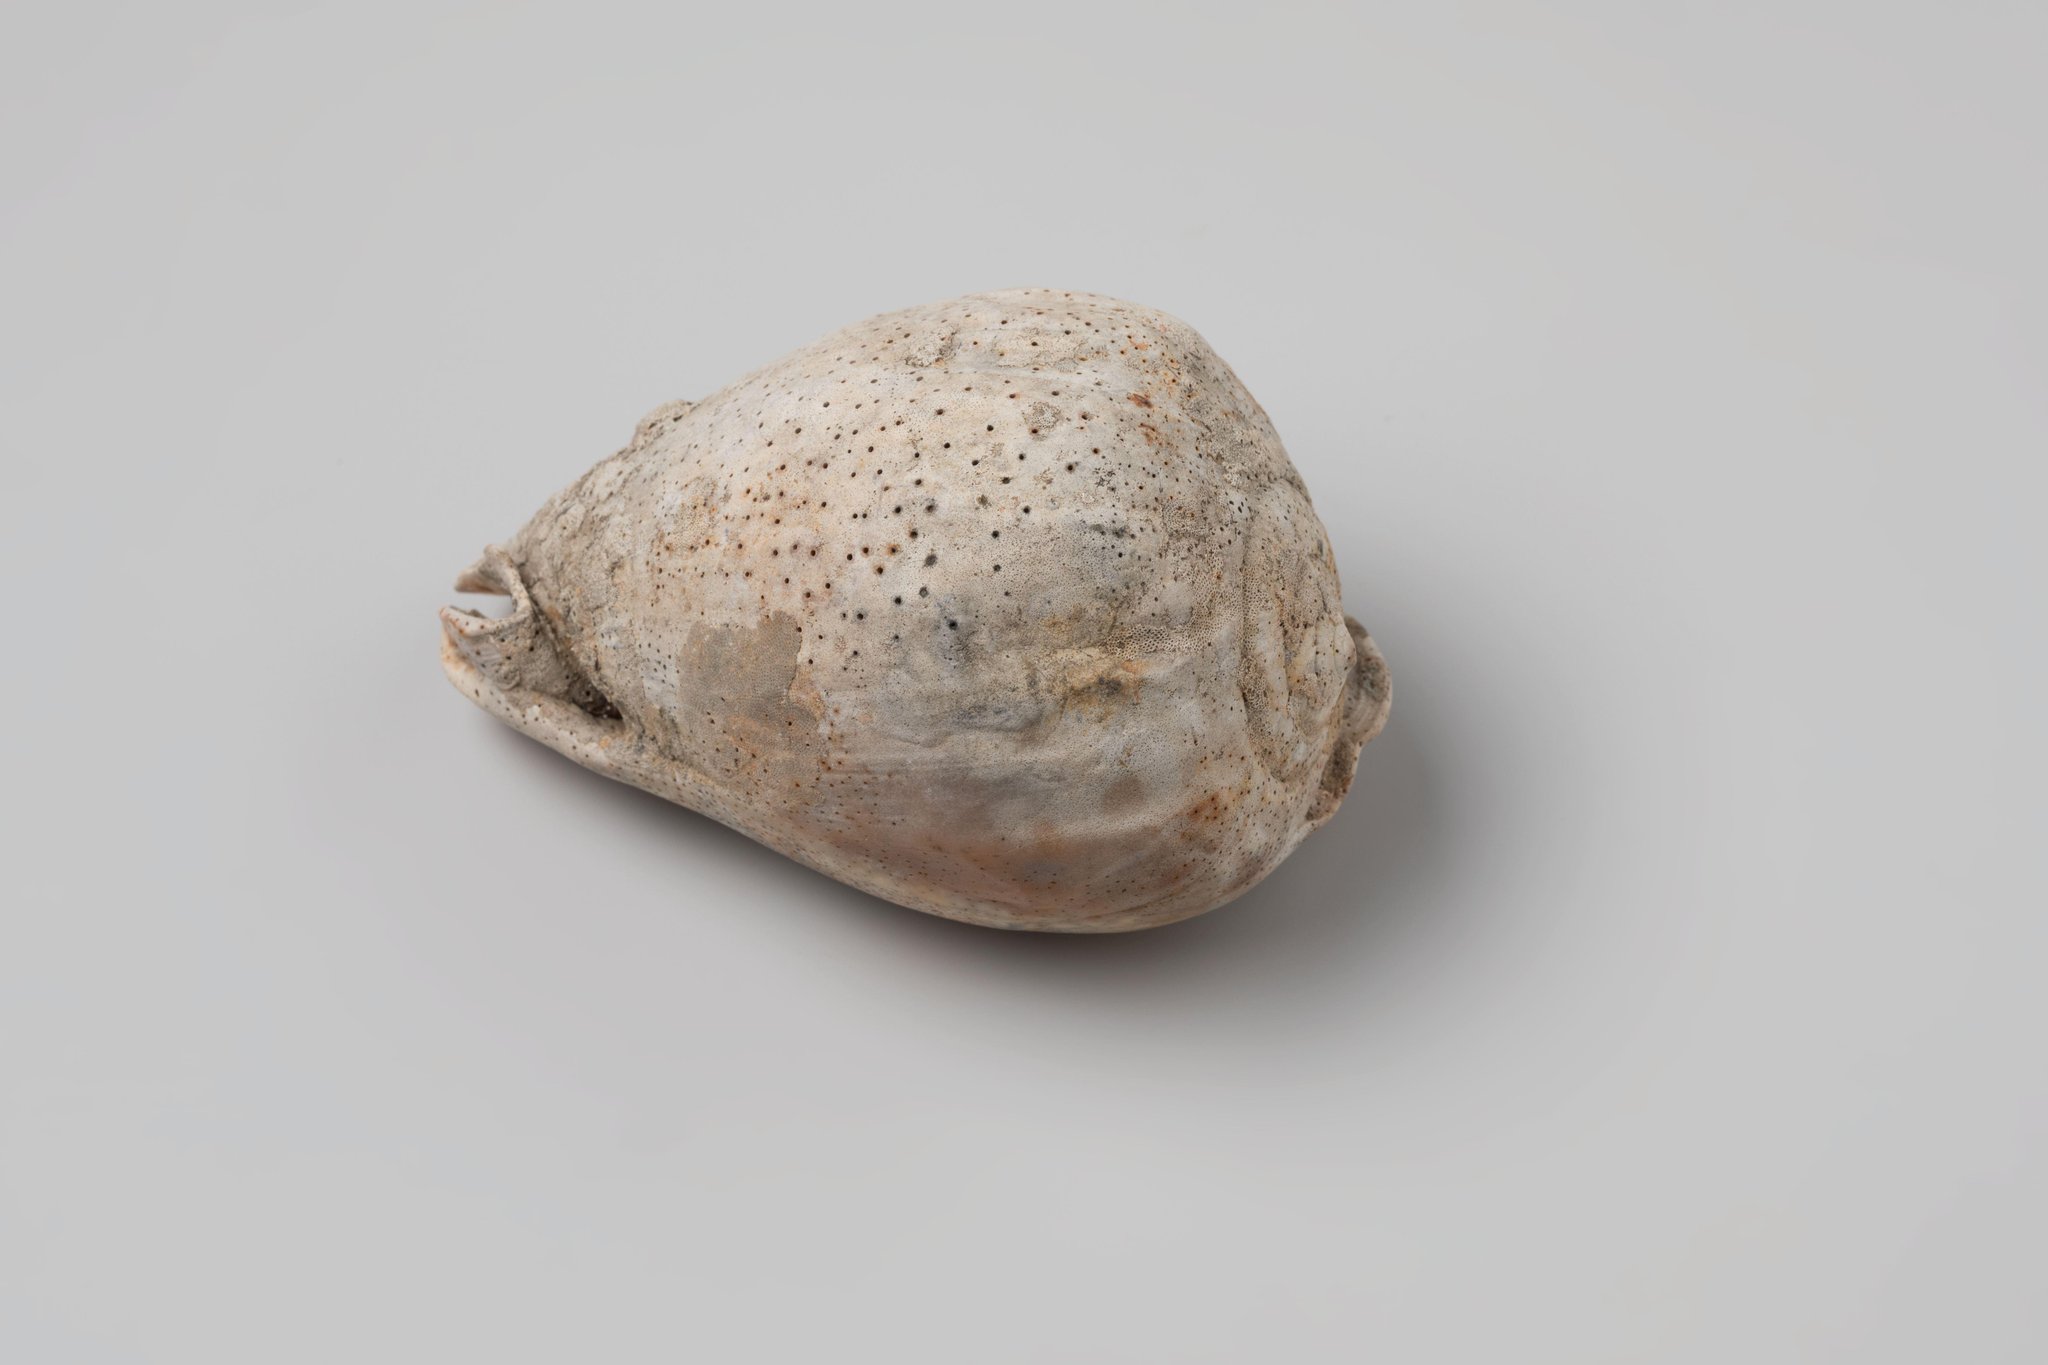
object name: cypraecassis testiculus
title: Cypraecassis testiculus shell from the wreck of the Dutch East India ship Witte Leeuw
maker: niet van toepassing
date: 1613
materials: shell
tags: verenigde oostindische compagnie, sint-helena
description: Schelp uit V.O.C.-schip de 'Witte Leeuw'.